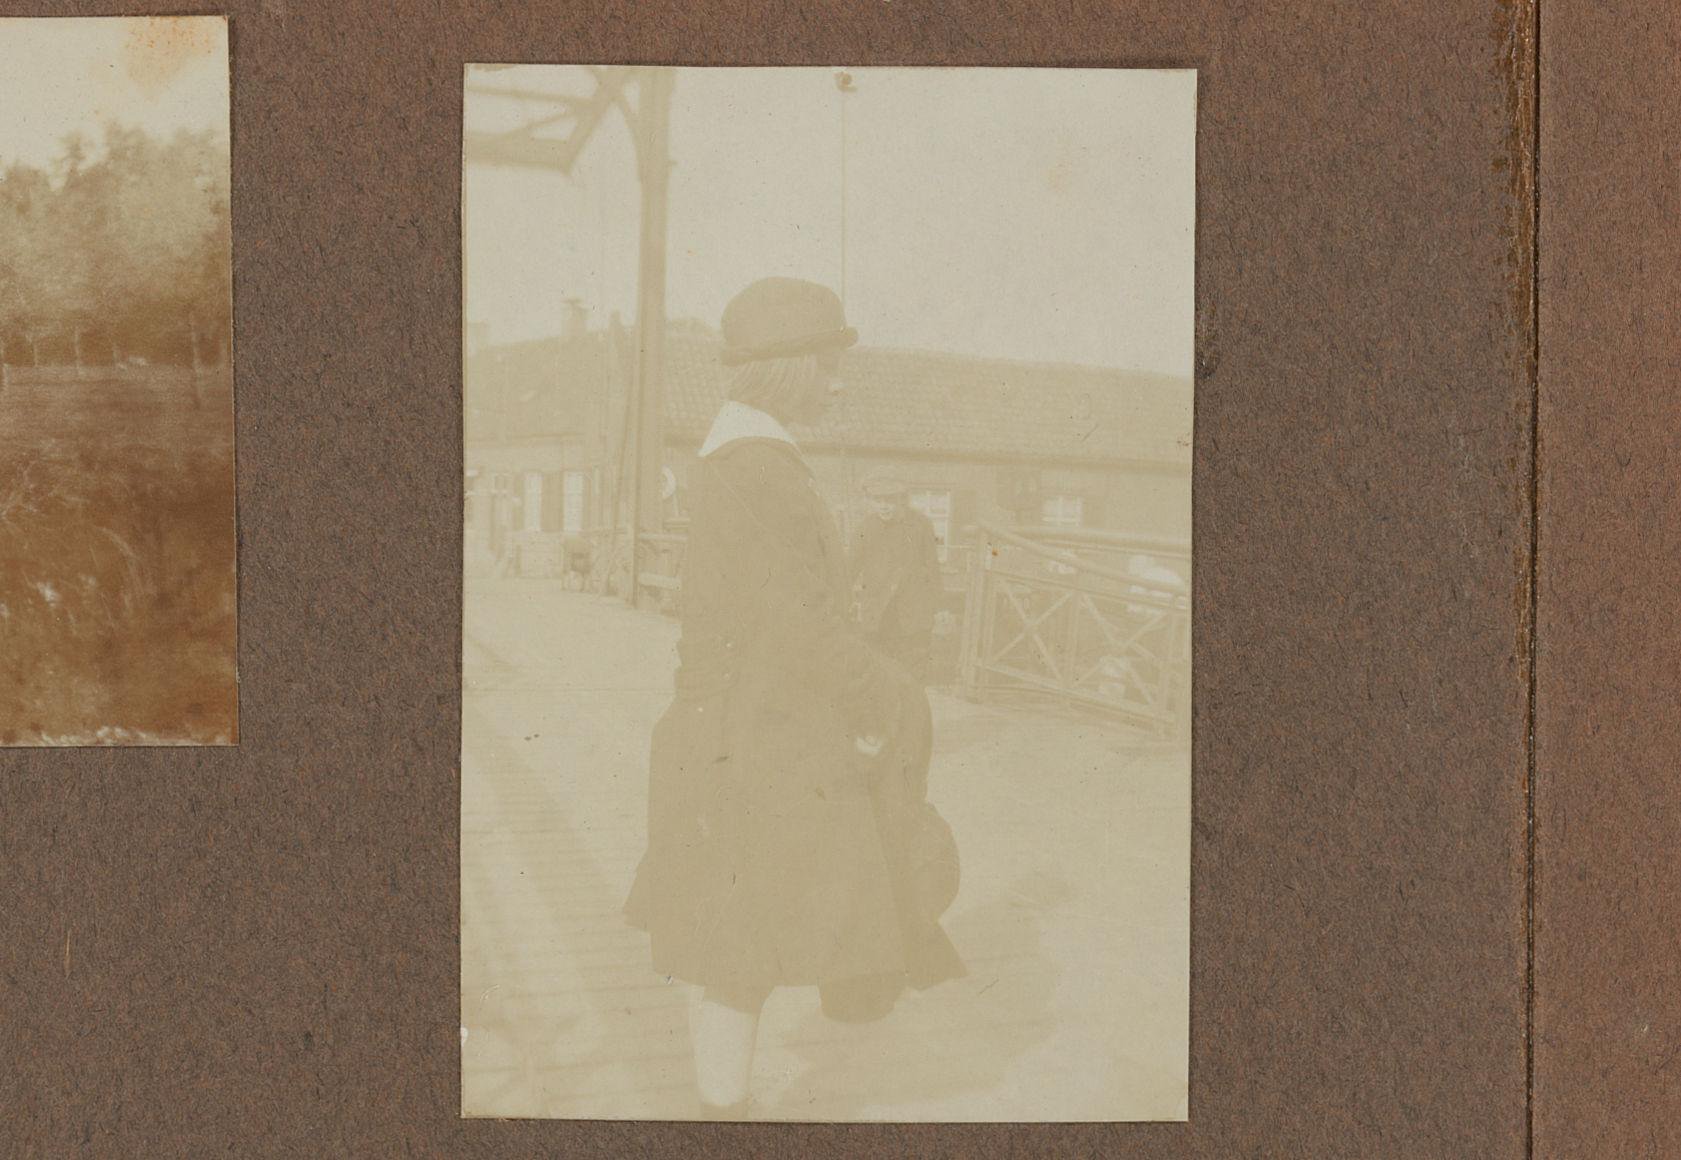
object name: photograph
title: Staande jonge vrouw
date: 1908-1915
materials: photographic support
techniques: photography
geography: netherlands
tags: netherlands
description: Foto op bruin albumblad 48 van familiealbum van Alphons Diepenbrock.